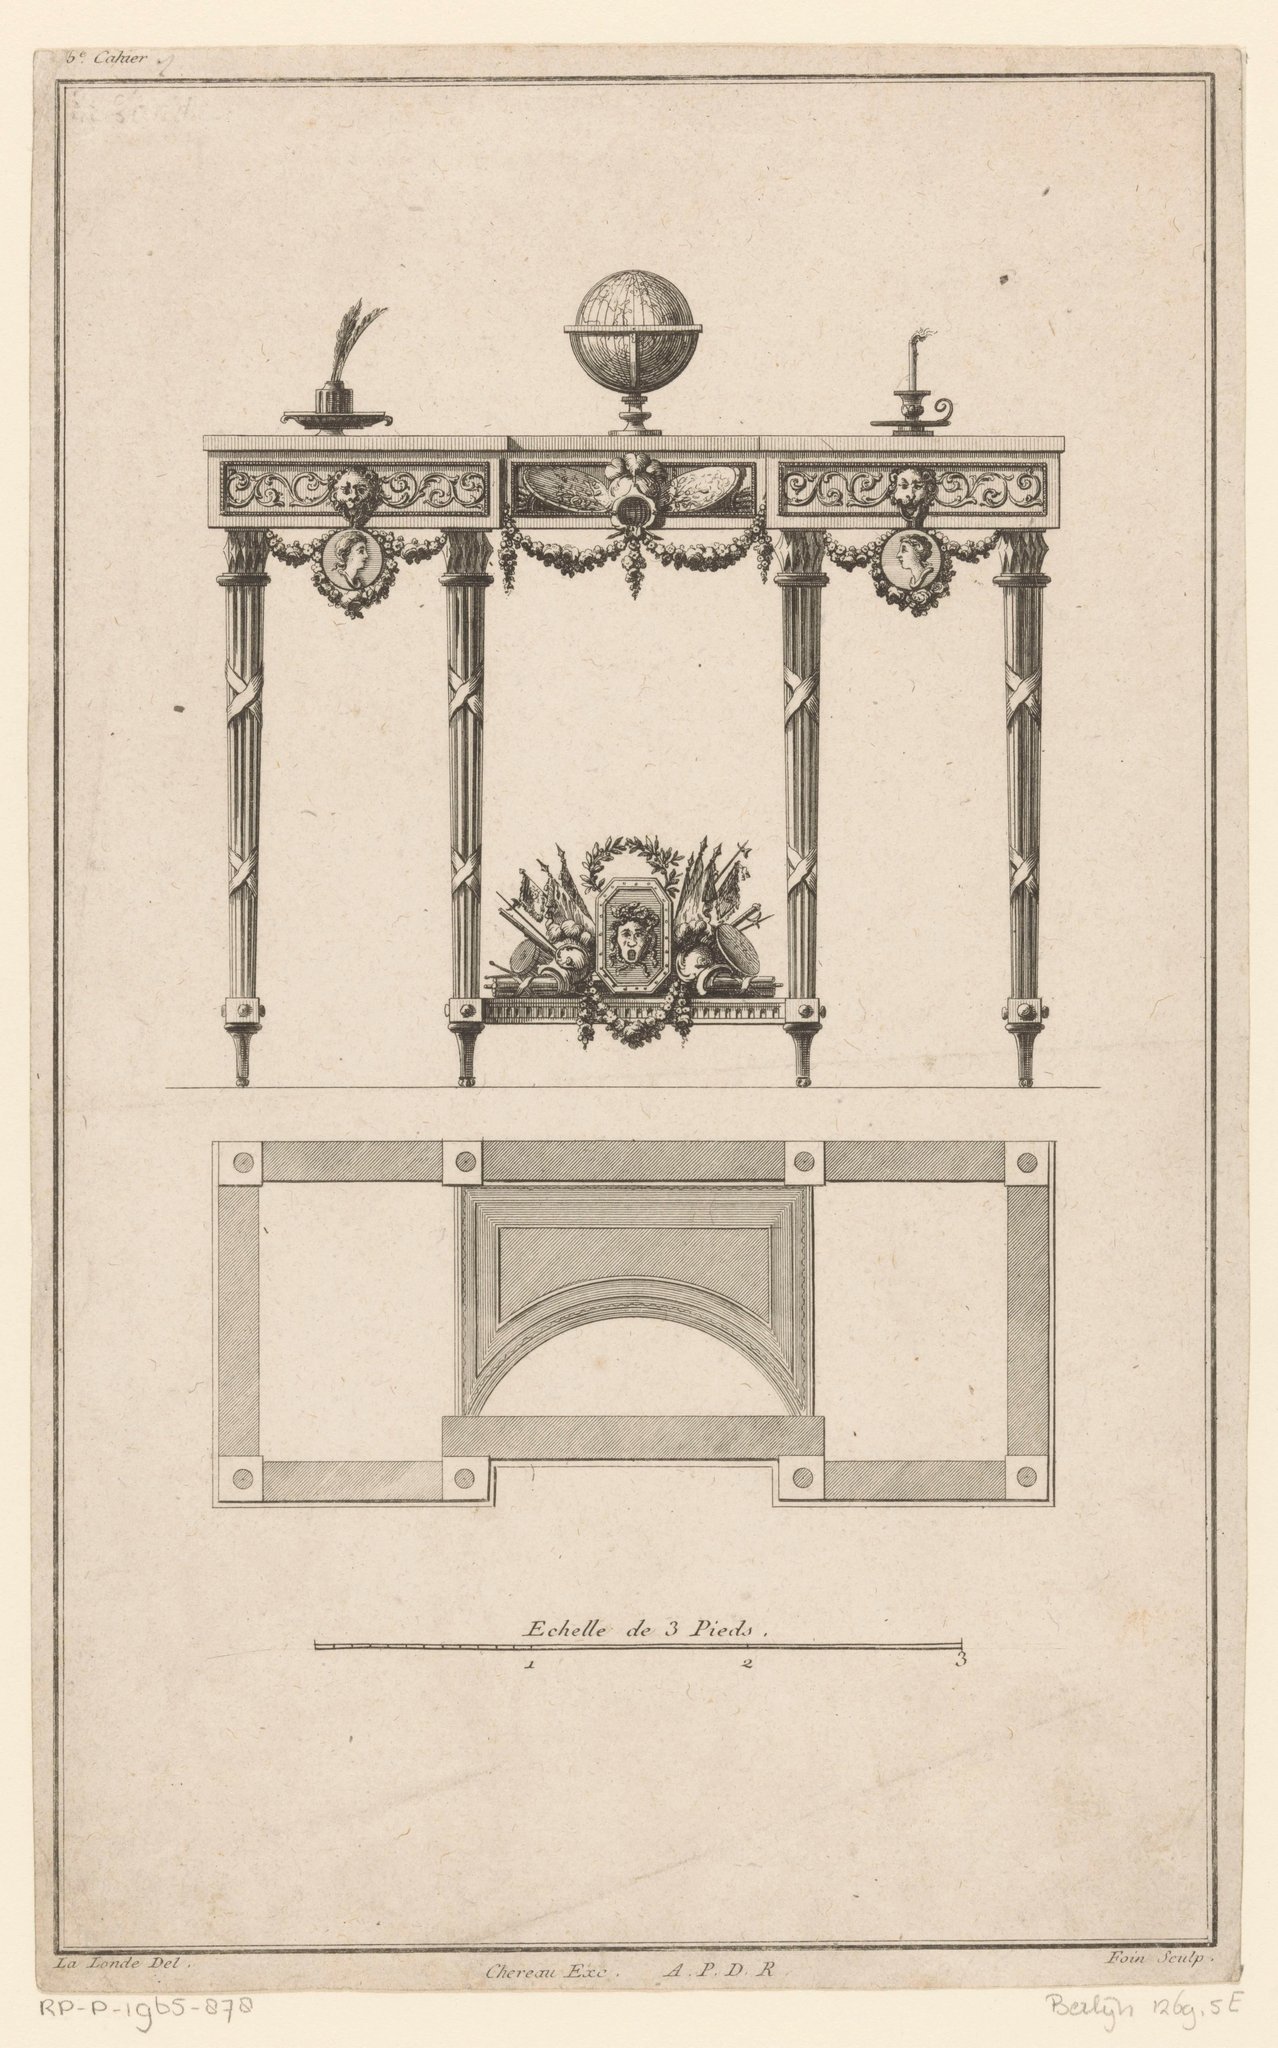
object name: print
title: Rechthoekige tafel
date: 1784-1785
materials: paper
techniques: engraving, etching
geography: paris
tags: table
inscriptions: collector's mark: Lugt 2228, collector's mark: Lugt 2760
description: Voor- en bovenaanzicht van een geornamenteerde rechthoekige tafel met een schild en wapens. Bovenop de tafel staan een inktpot, een globe en een kandelaar.